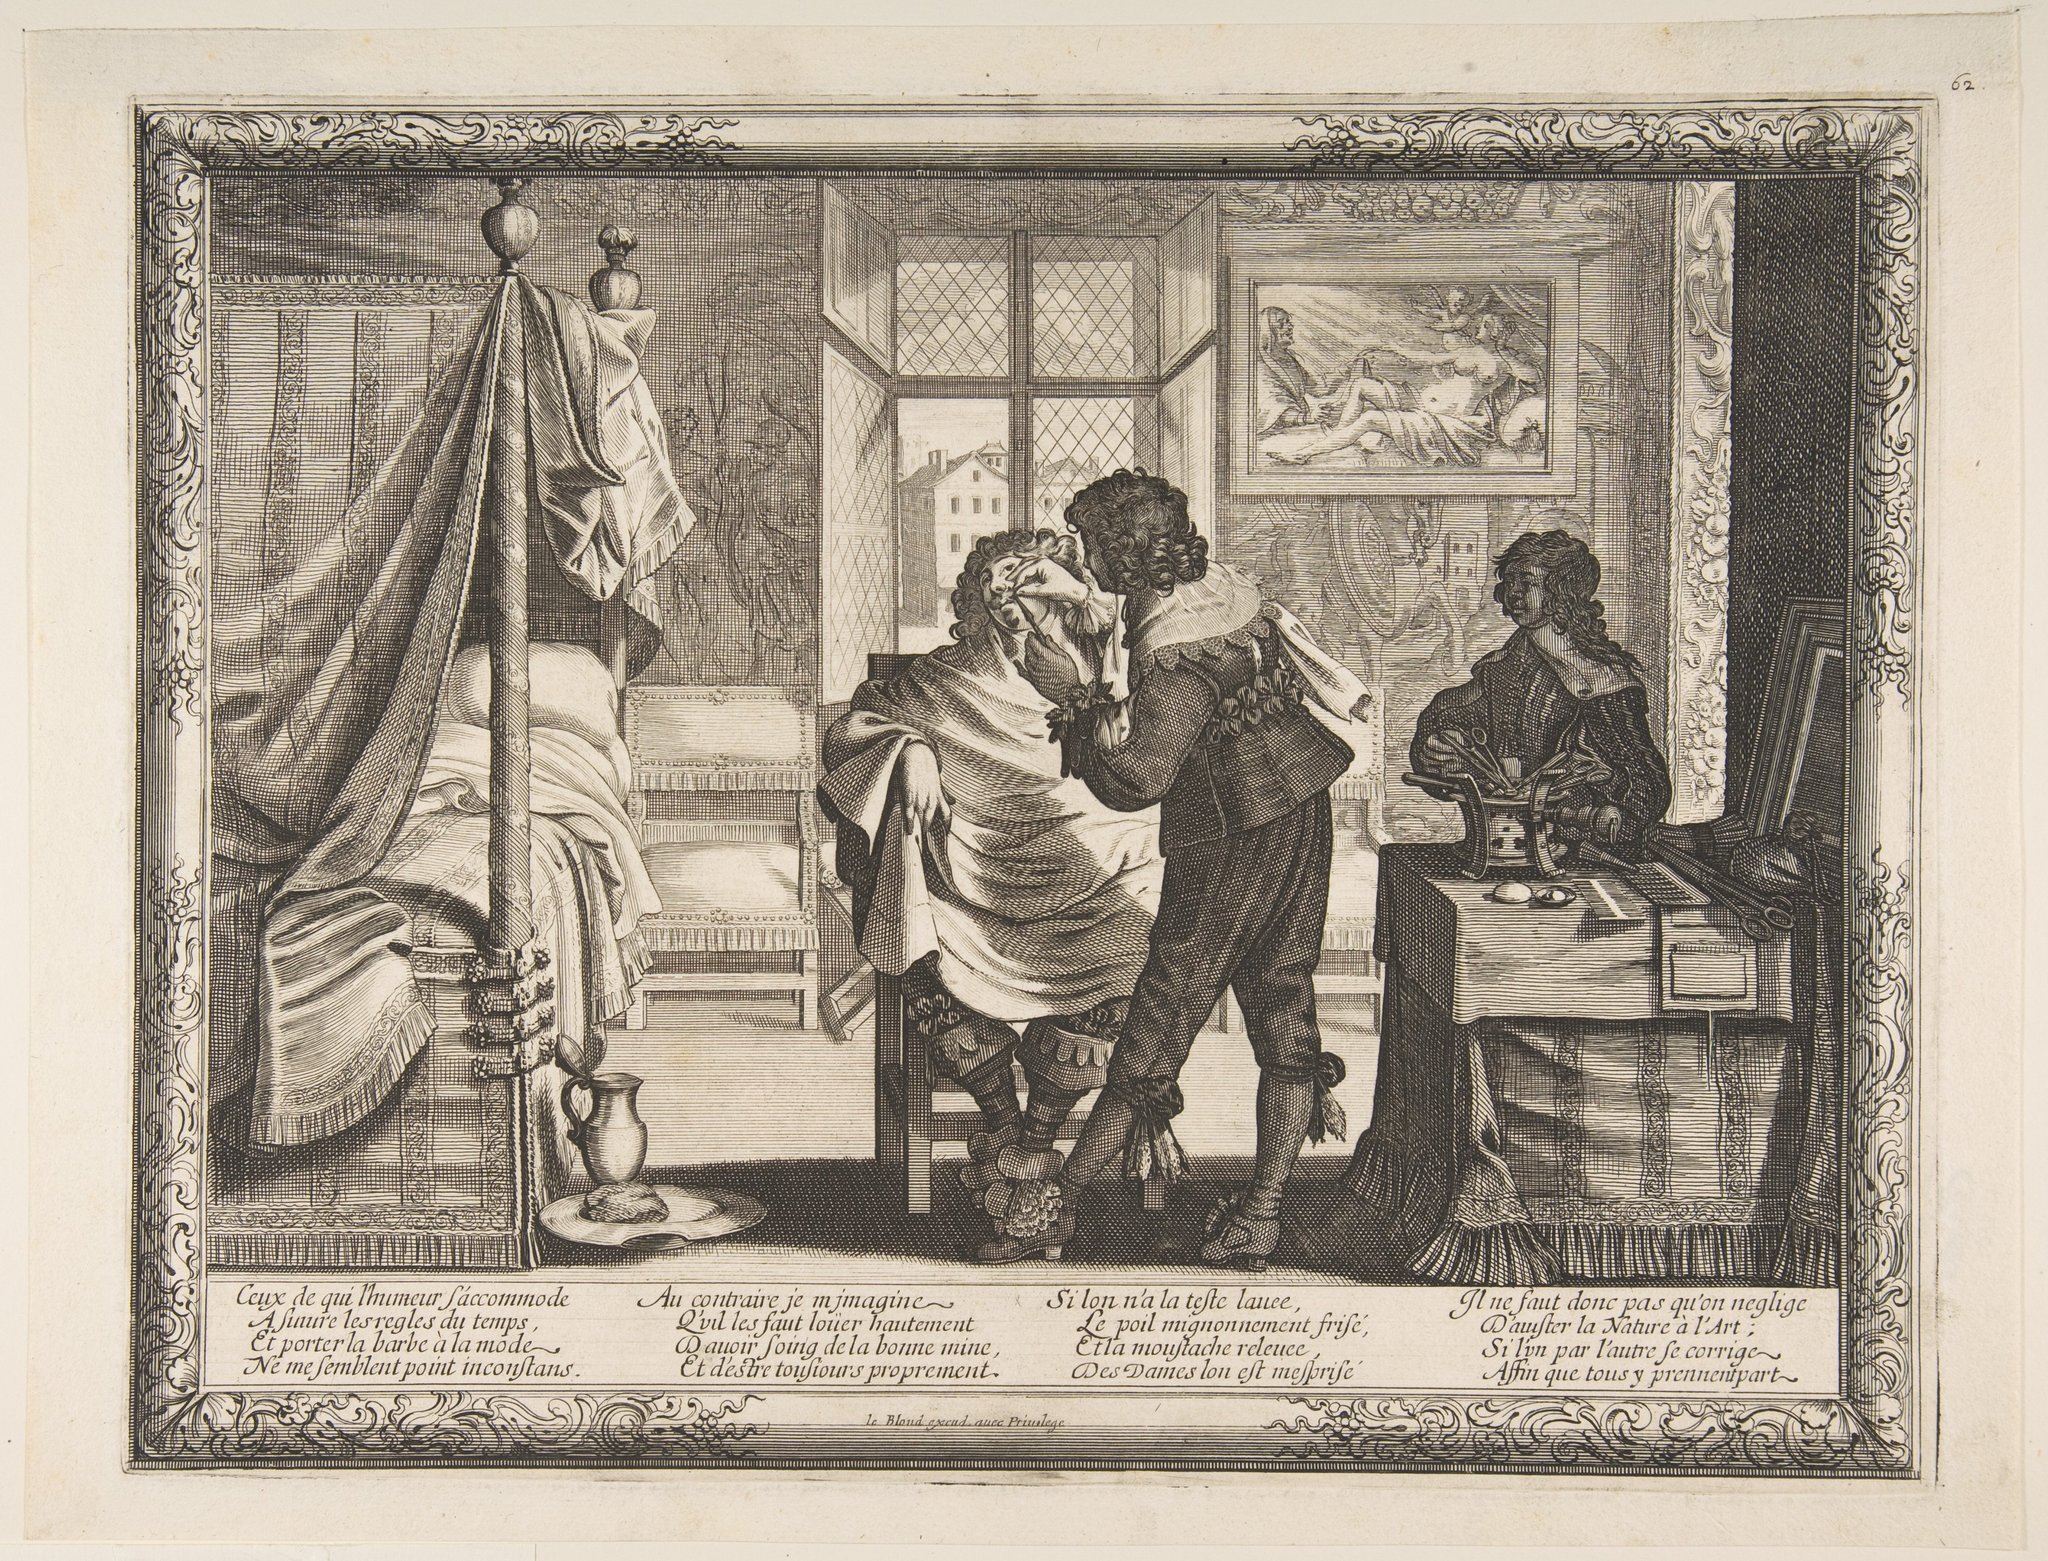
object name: print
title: The Barber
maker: abraham bosse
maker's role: artist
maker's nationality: french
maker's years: 1602-1676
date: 1632-1633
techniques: etching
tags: men,working,chairs